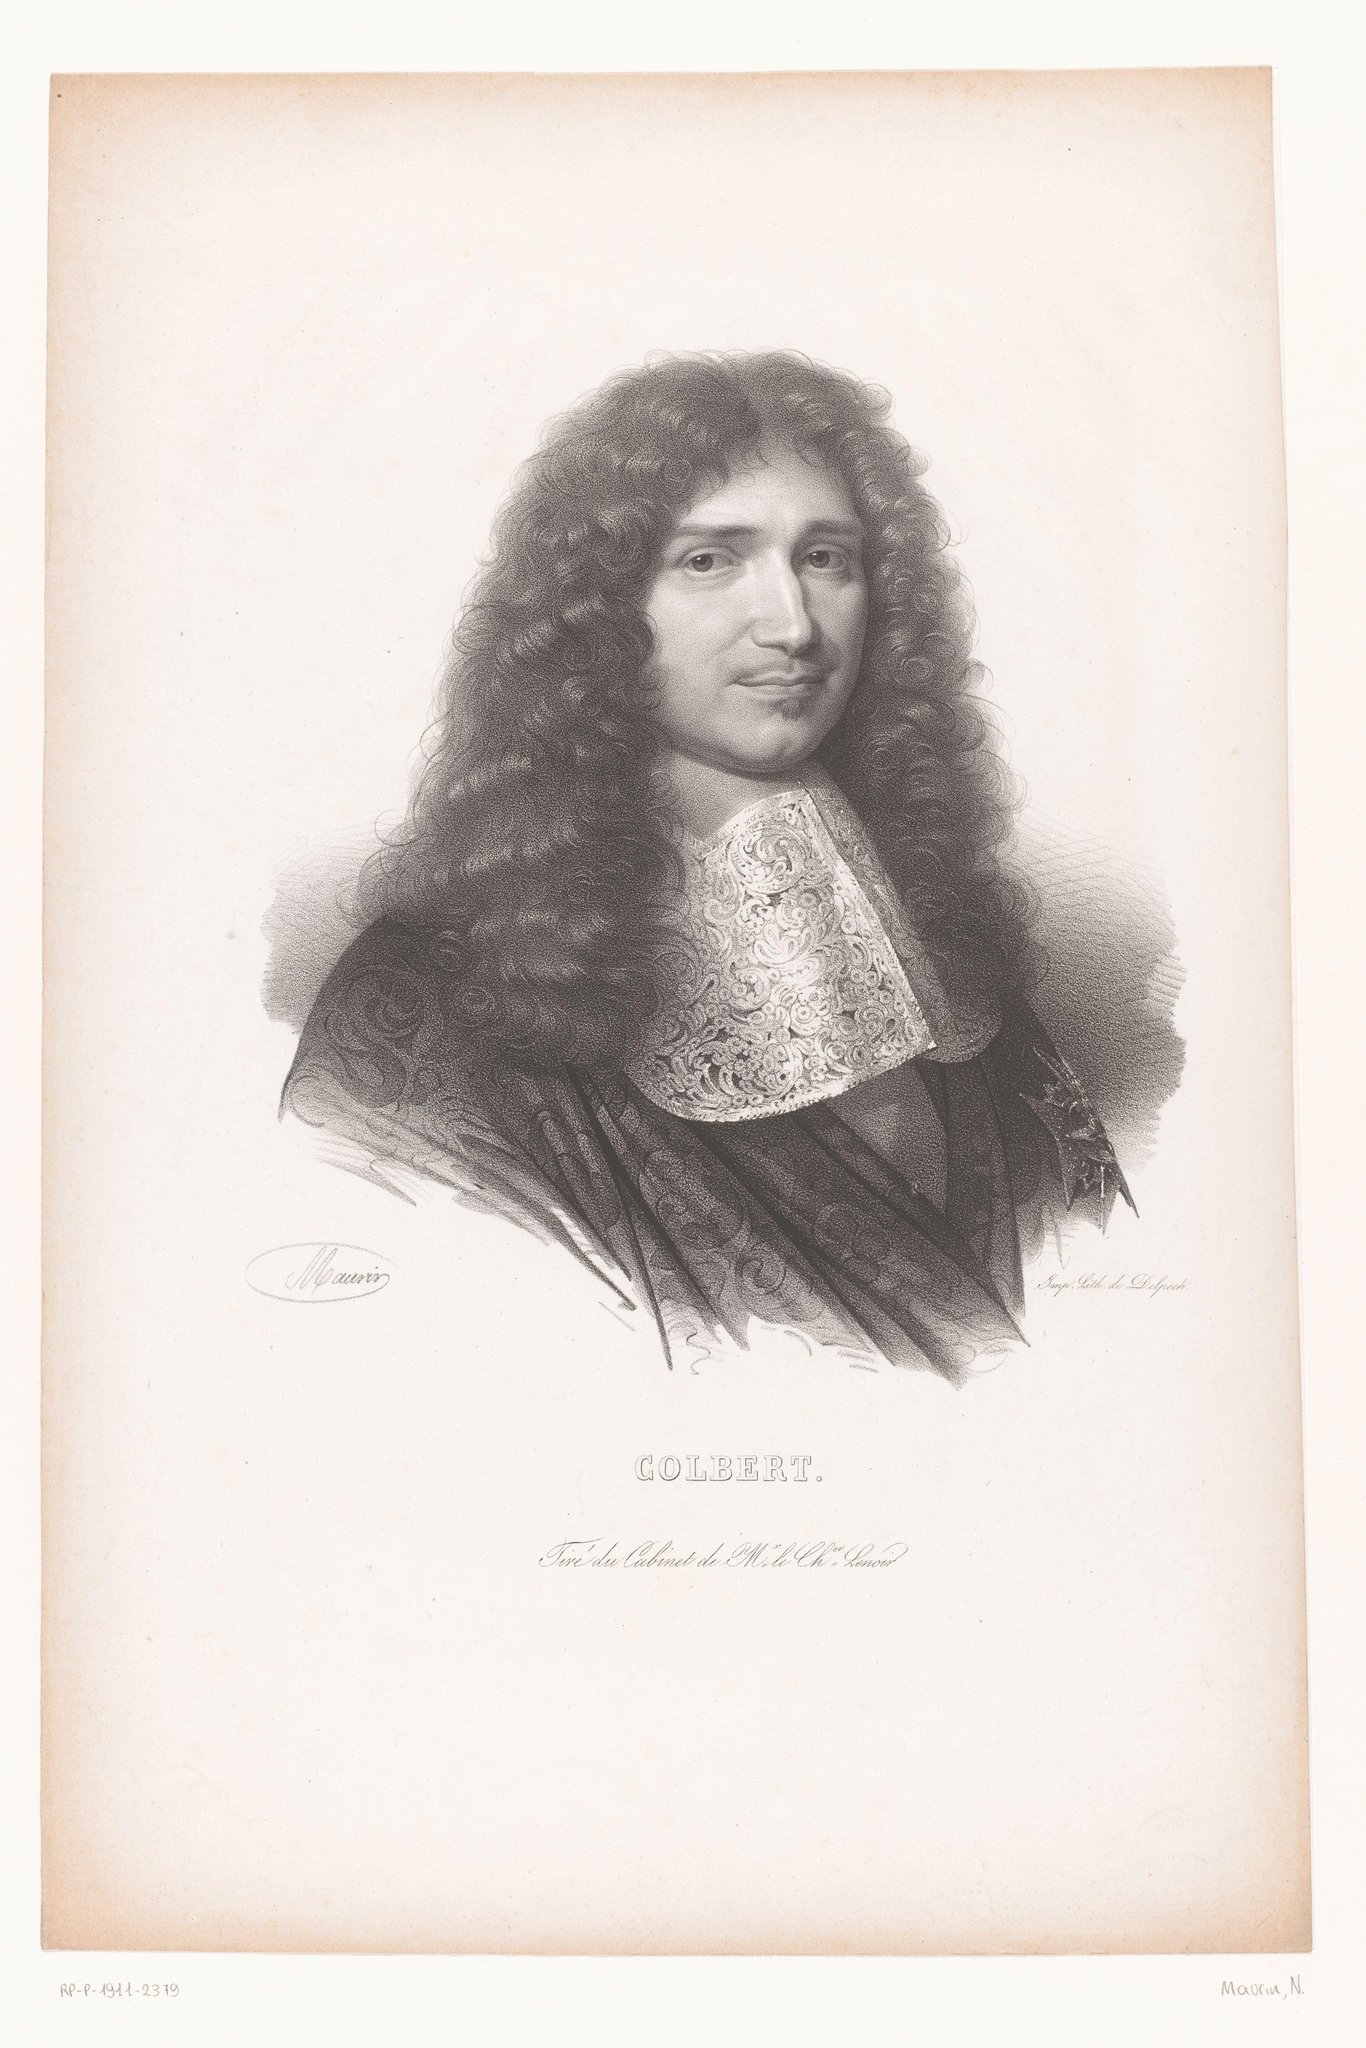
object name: print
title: Colbert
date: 1825-1842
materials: paper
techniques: lithograph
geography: paris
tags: paris, politician, jean-baptiste colbert, historical persons, politician, e.g. party leader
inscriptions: collector's mark: Lugt 2228